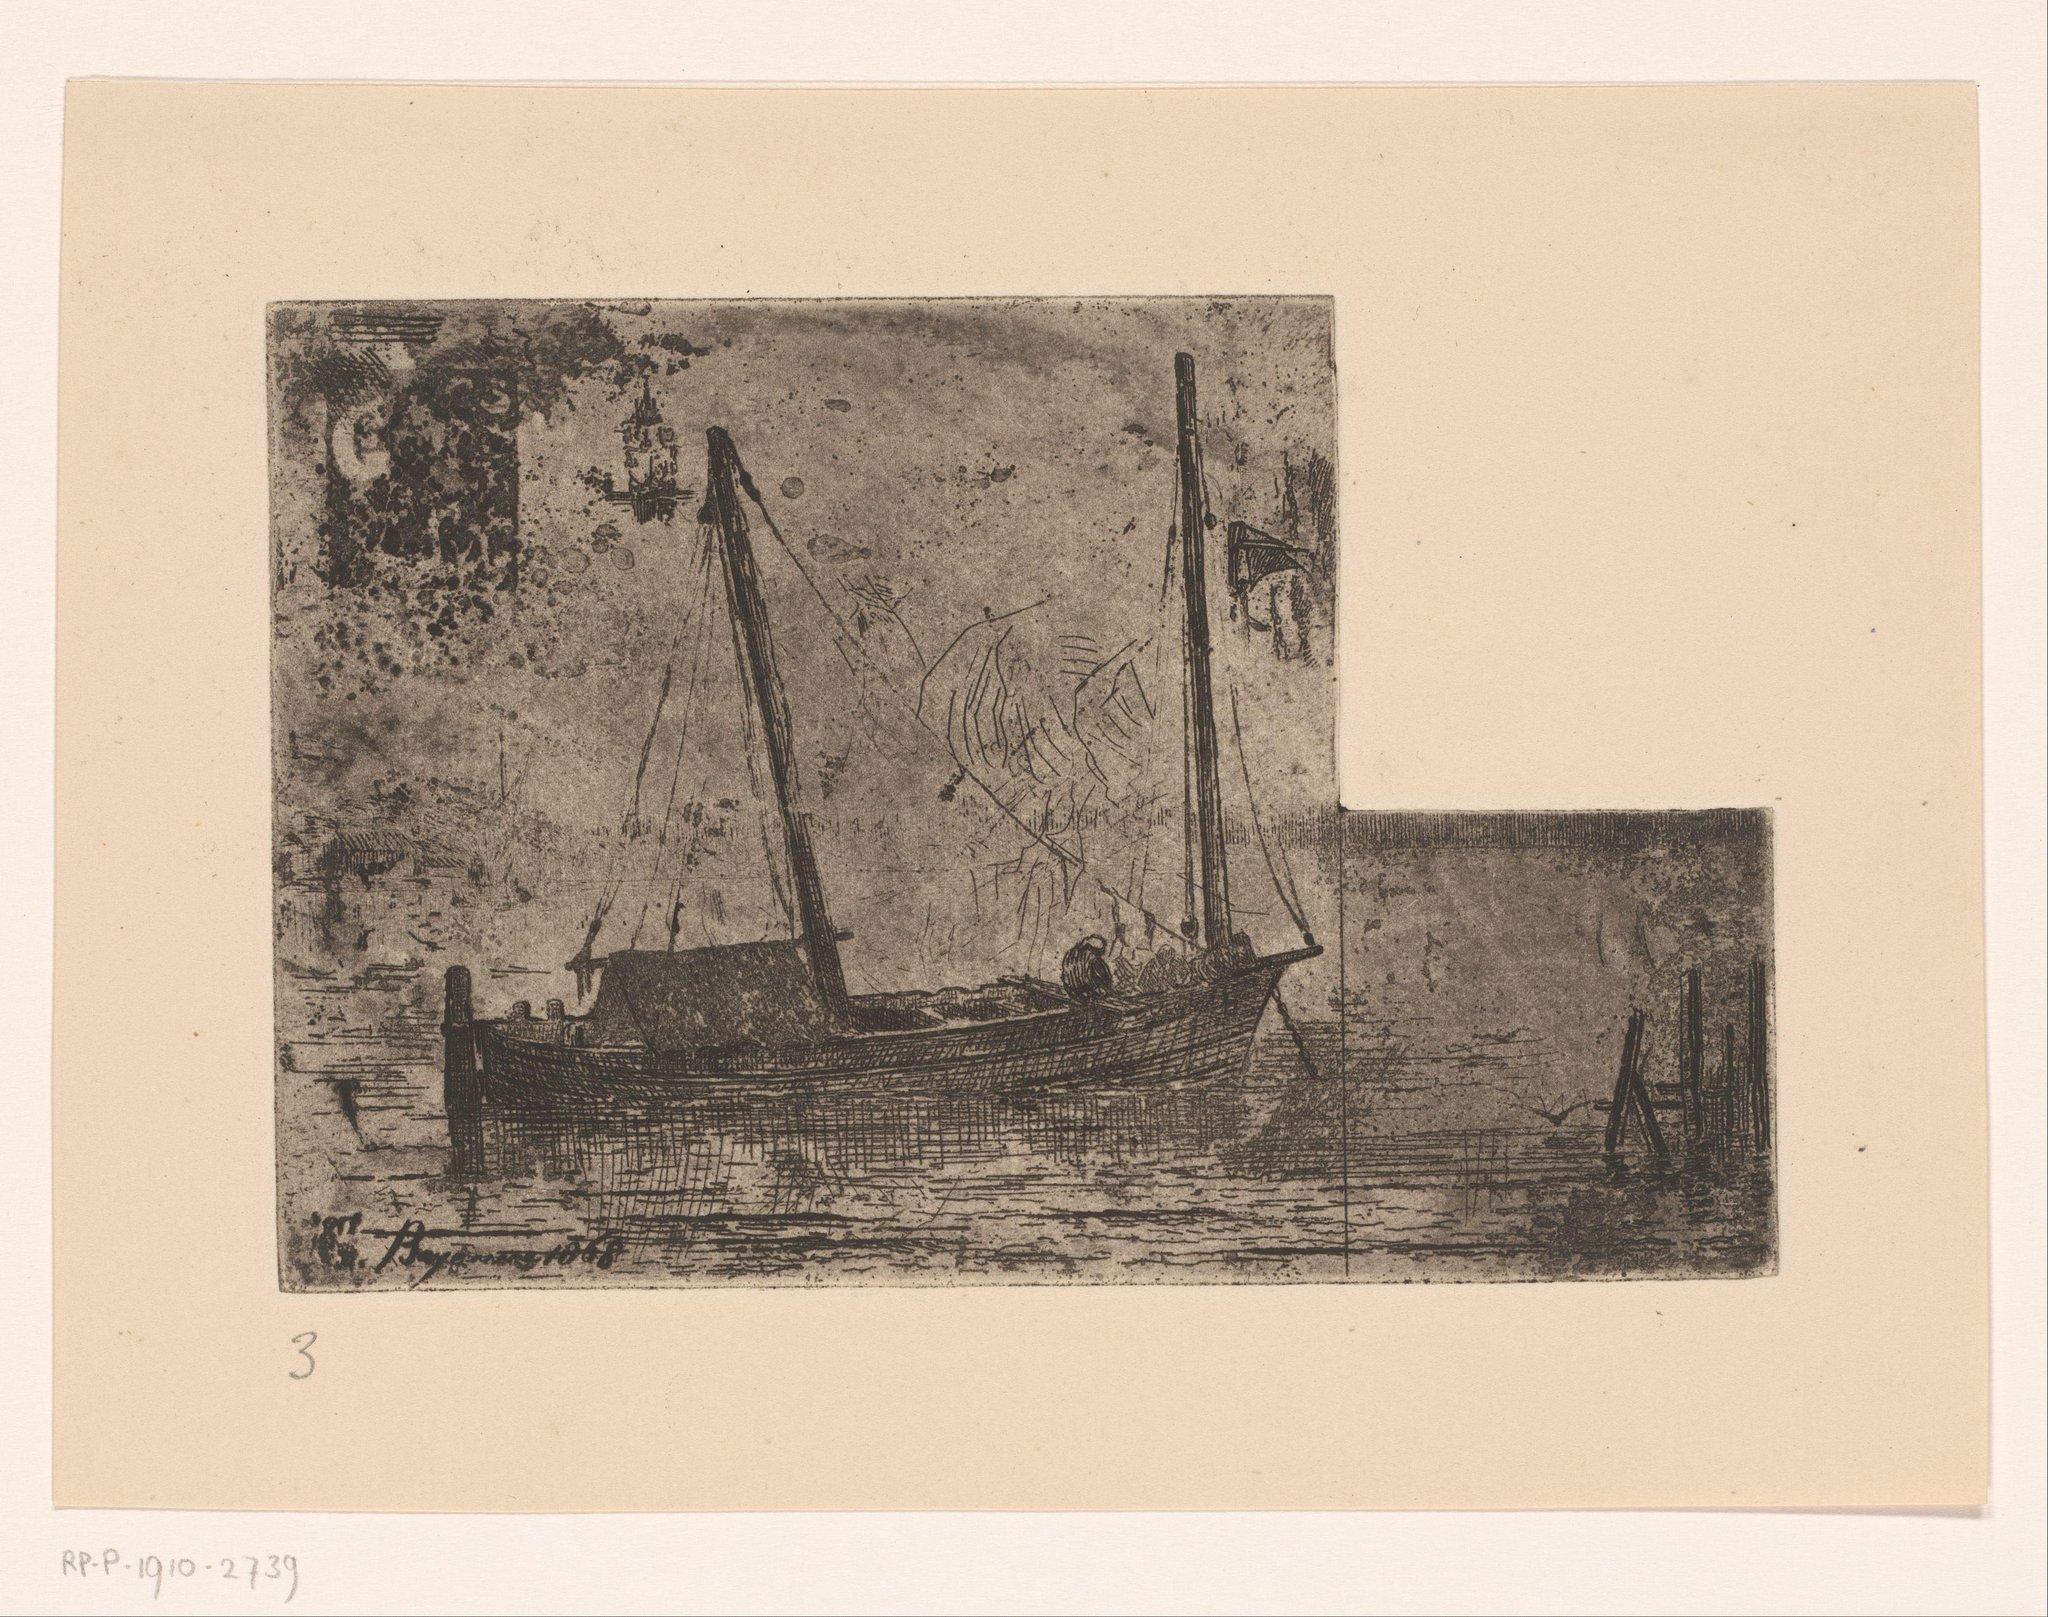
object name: print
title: Boot op de Adour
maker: carel nicolaas storm van s-gravesande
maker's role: draughtsman, print maker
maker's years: 1841-1924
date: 1870-1871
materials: paper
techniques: etching, intaglio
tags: sailing-ship, sailing-boat, river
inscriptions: collector's mark: Lugt 2228